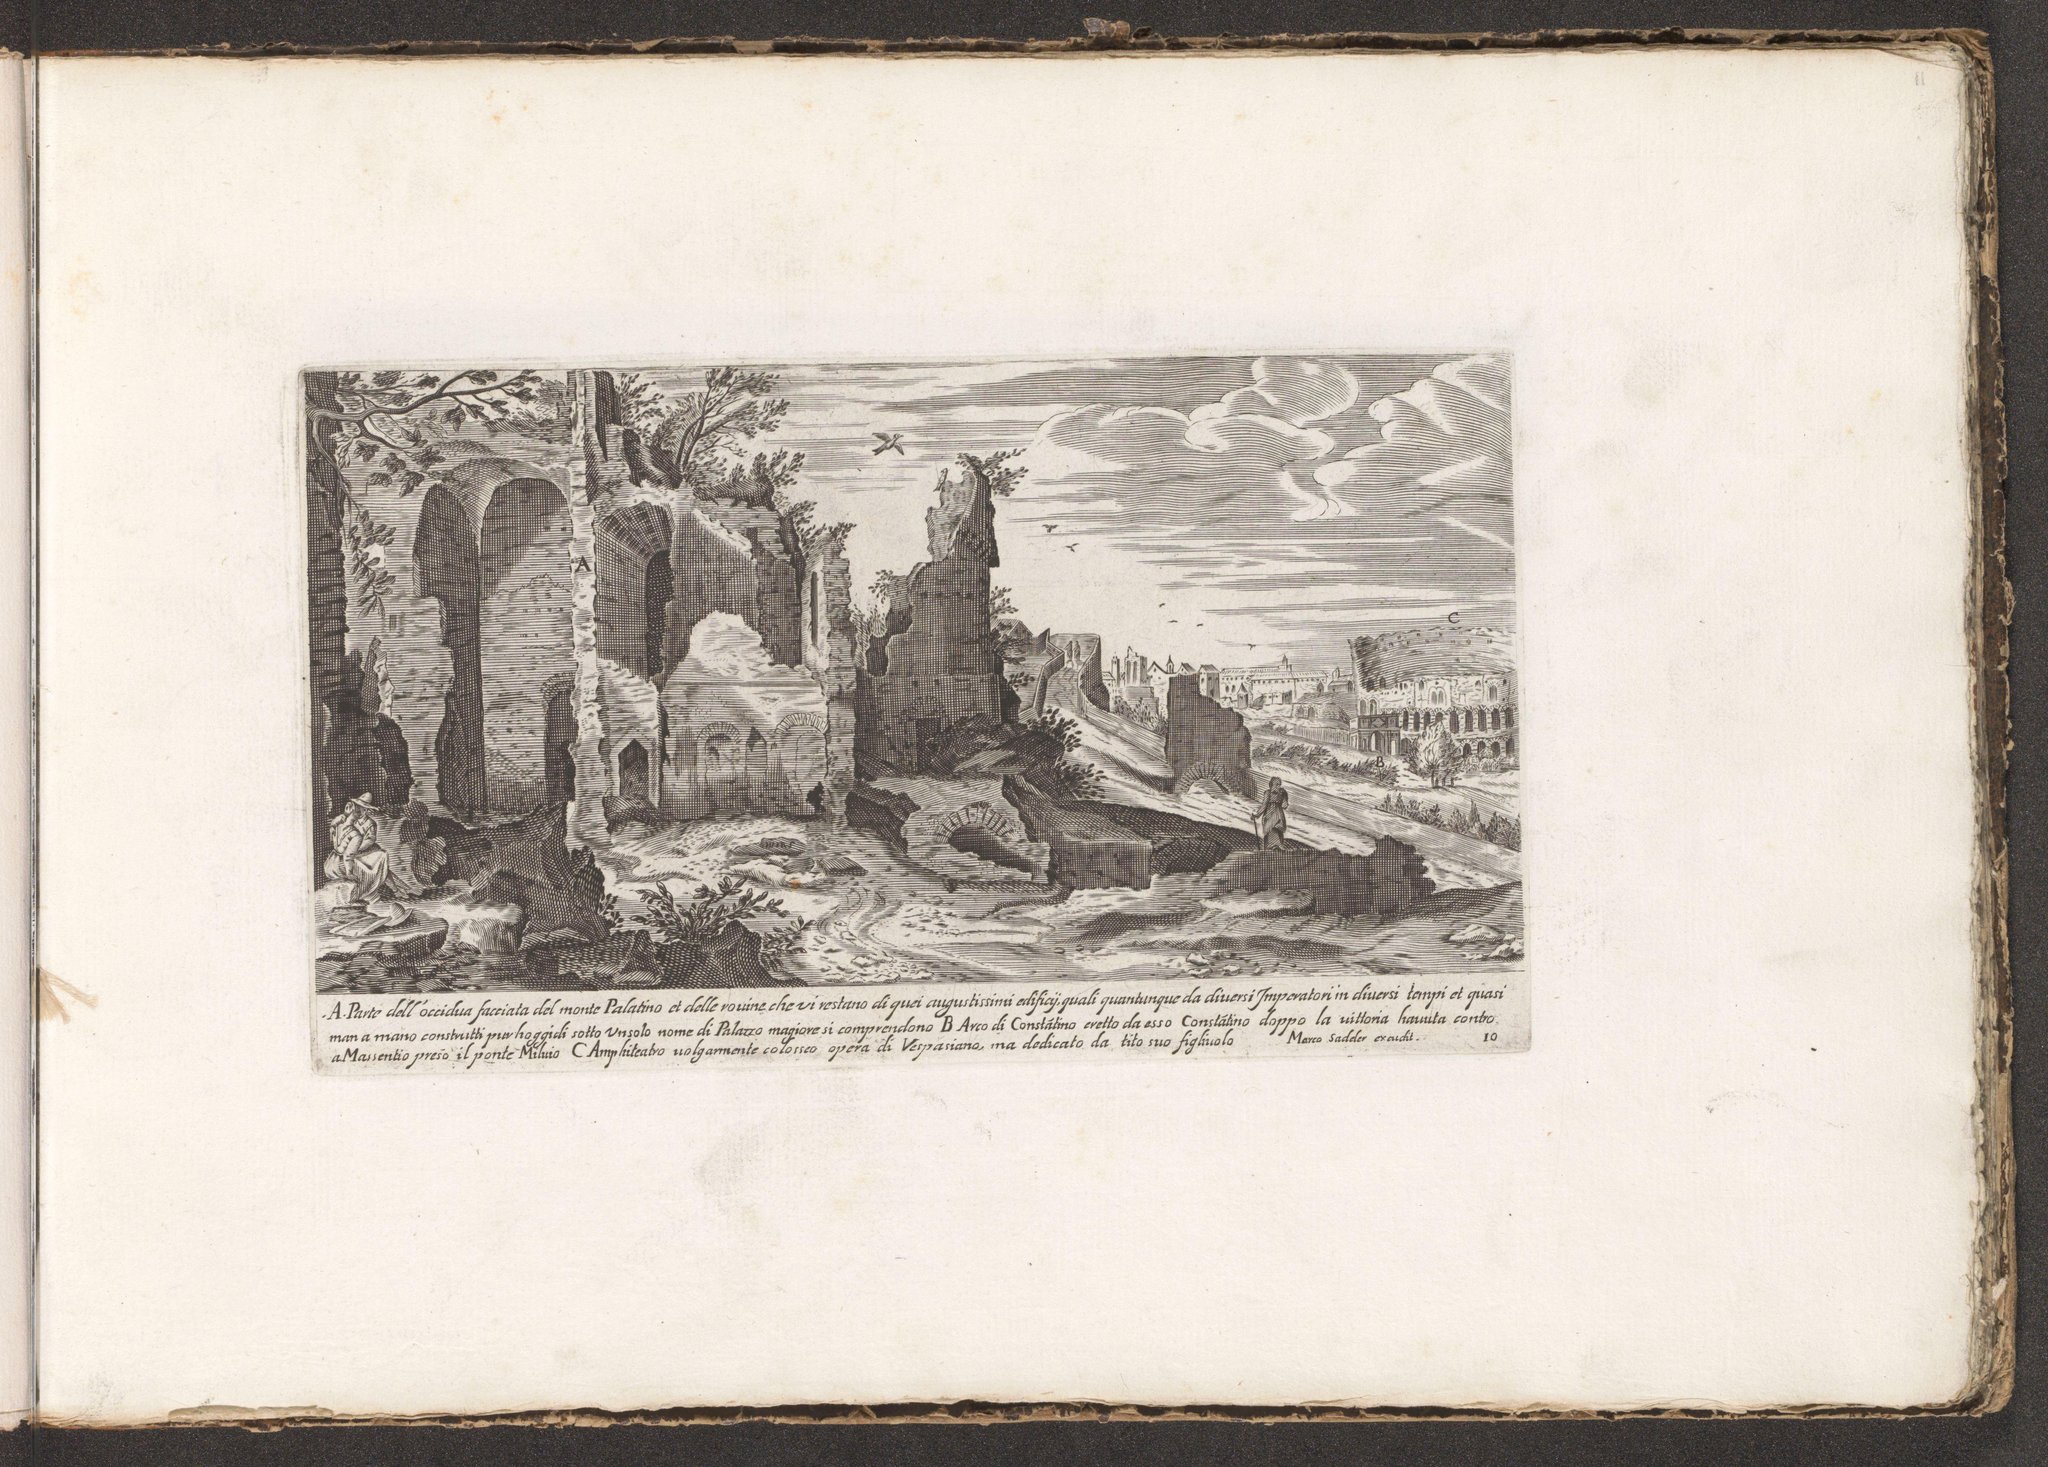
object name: album leaf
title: Ruïnes op de hellingen van de Palatijn, rechts het Colosseum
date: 1680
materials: paper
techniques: engraving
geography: prague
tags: arch of constantine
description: Gezicht op de hellingen van de Palatijn met rechts de boog van Constantijn en het Colosseum. Links een vrijend stelletje. In de ondermarge drie regels tekst in het Italiaans. De prent maakt deel uit van een album.